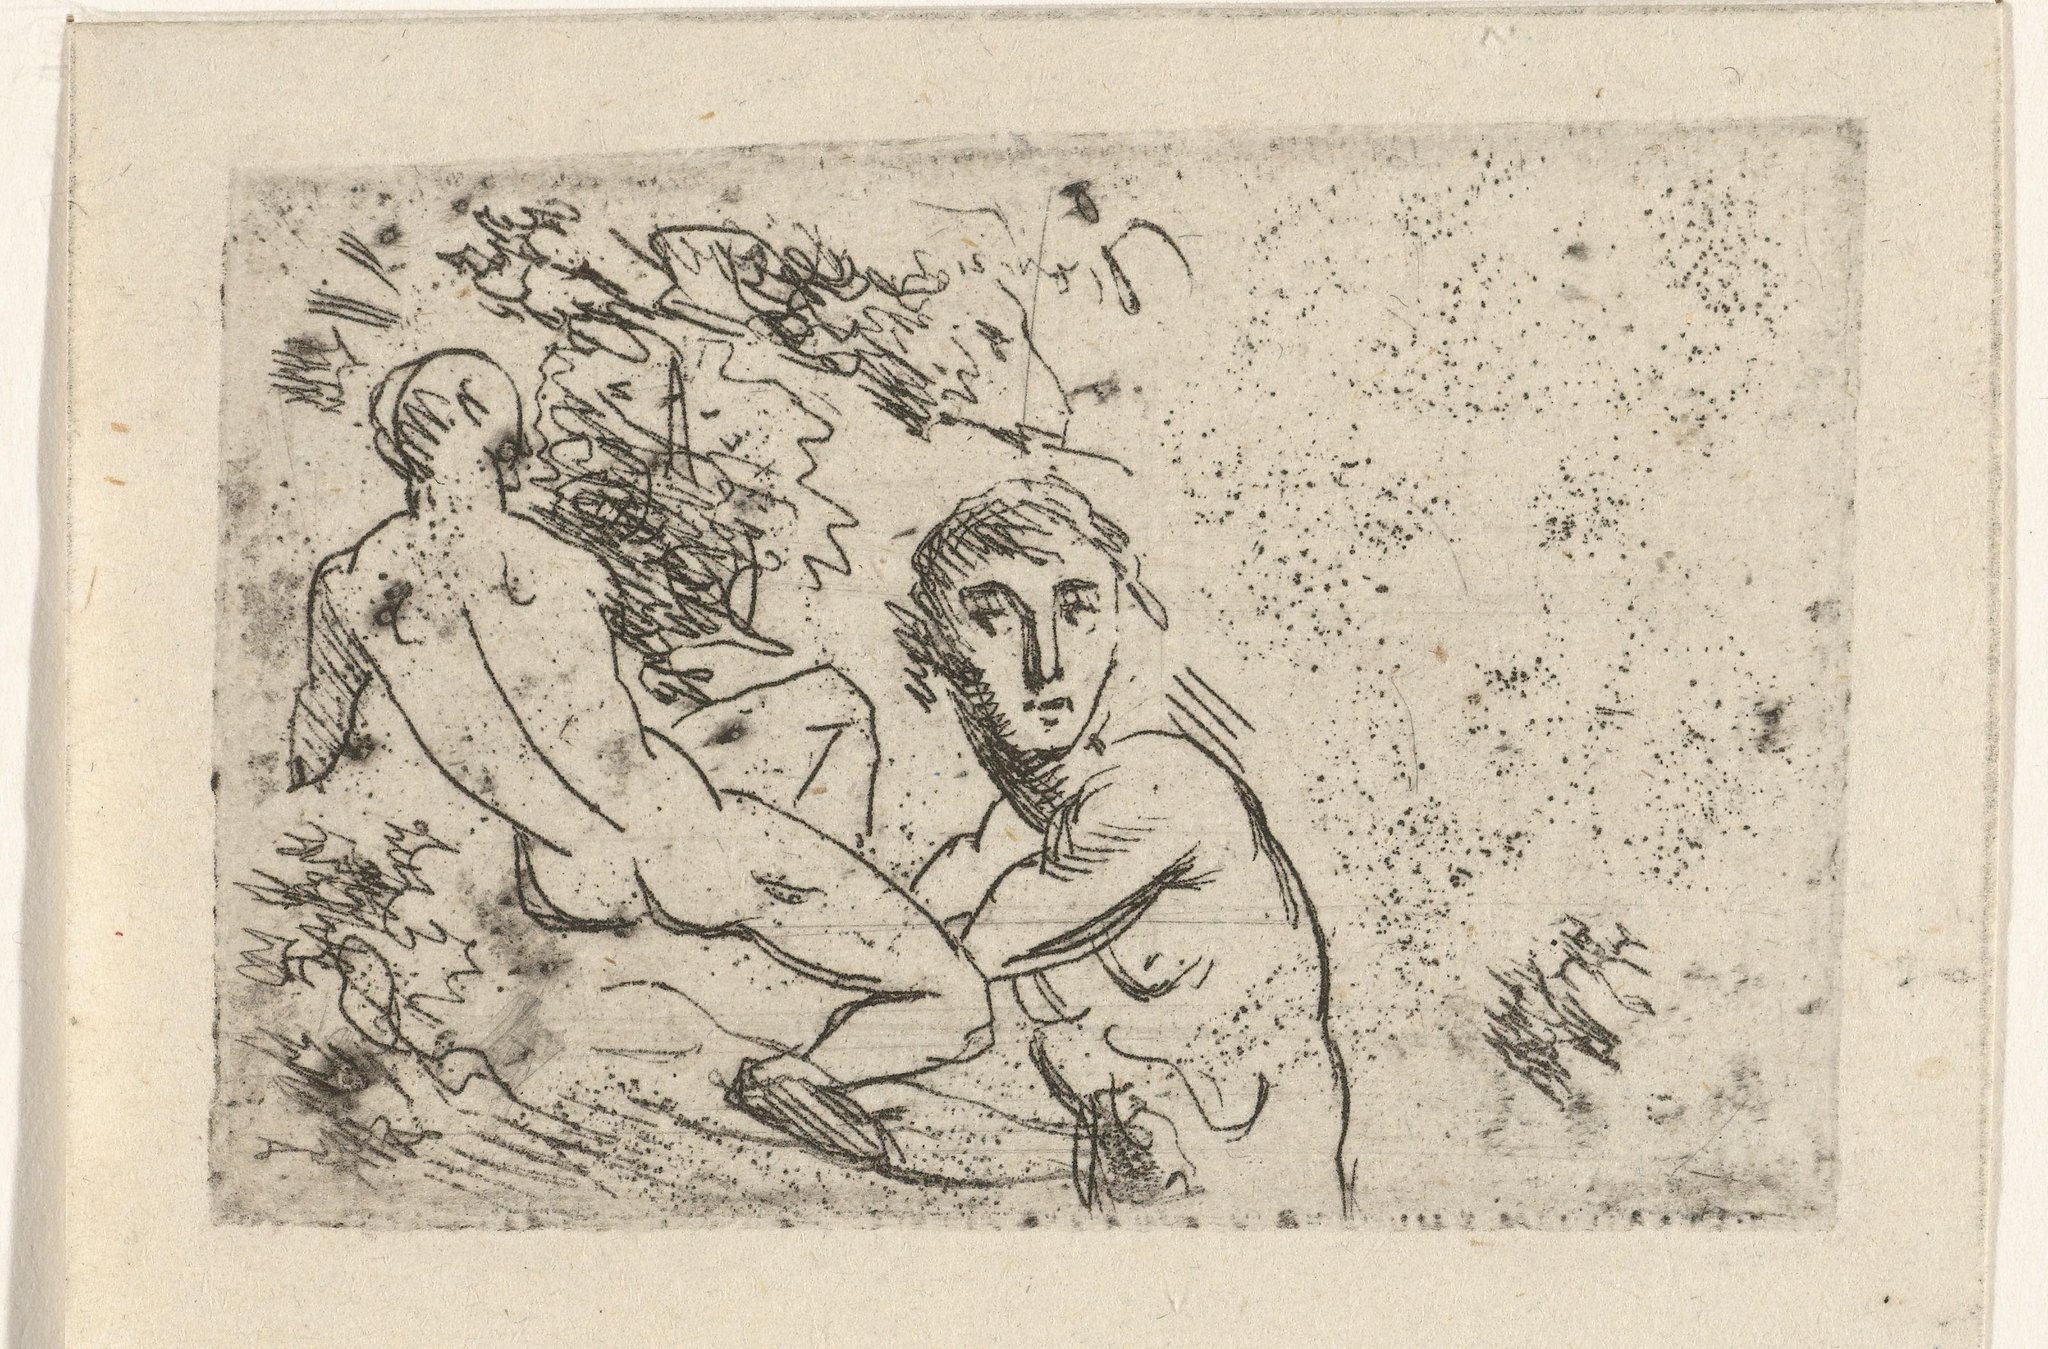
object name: print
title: Studieblad met naakt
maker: hermanus fock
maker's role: conservator, draughtsman, painter, print maker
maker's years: 1766-1822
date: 1781-1822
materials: paper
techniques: aquatint, etching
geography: amsterdam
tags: human figure of ideal proportions, e.g. academic nude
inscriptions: collector's mark: Lugt 2228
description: Studieblad met mannelijk naakt, op de rug gezien en een naakte man ten halven lijve.